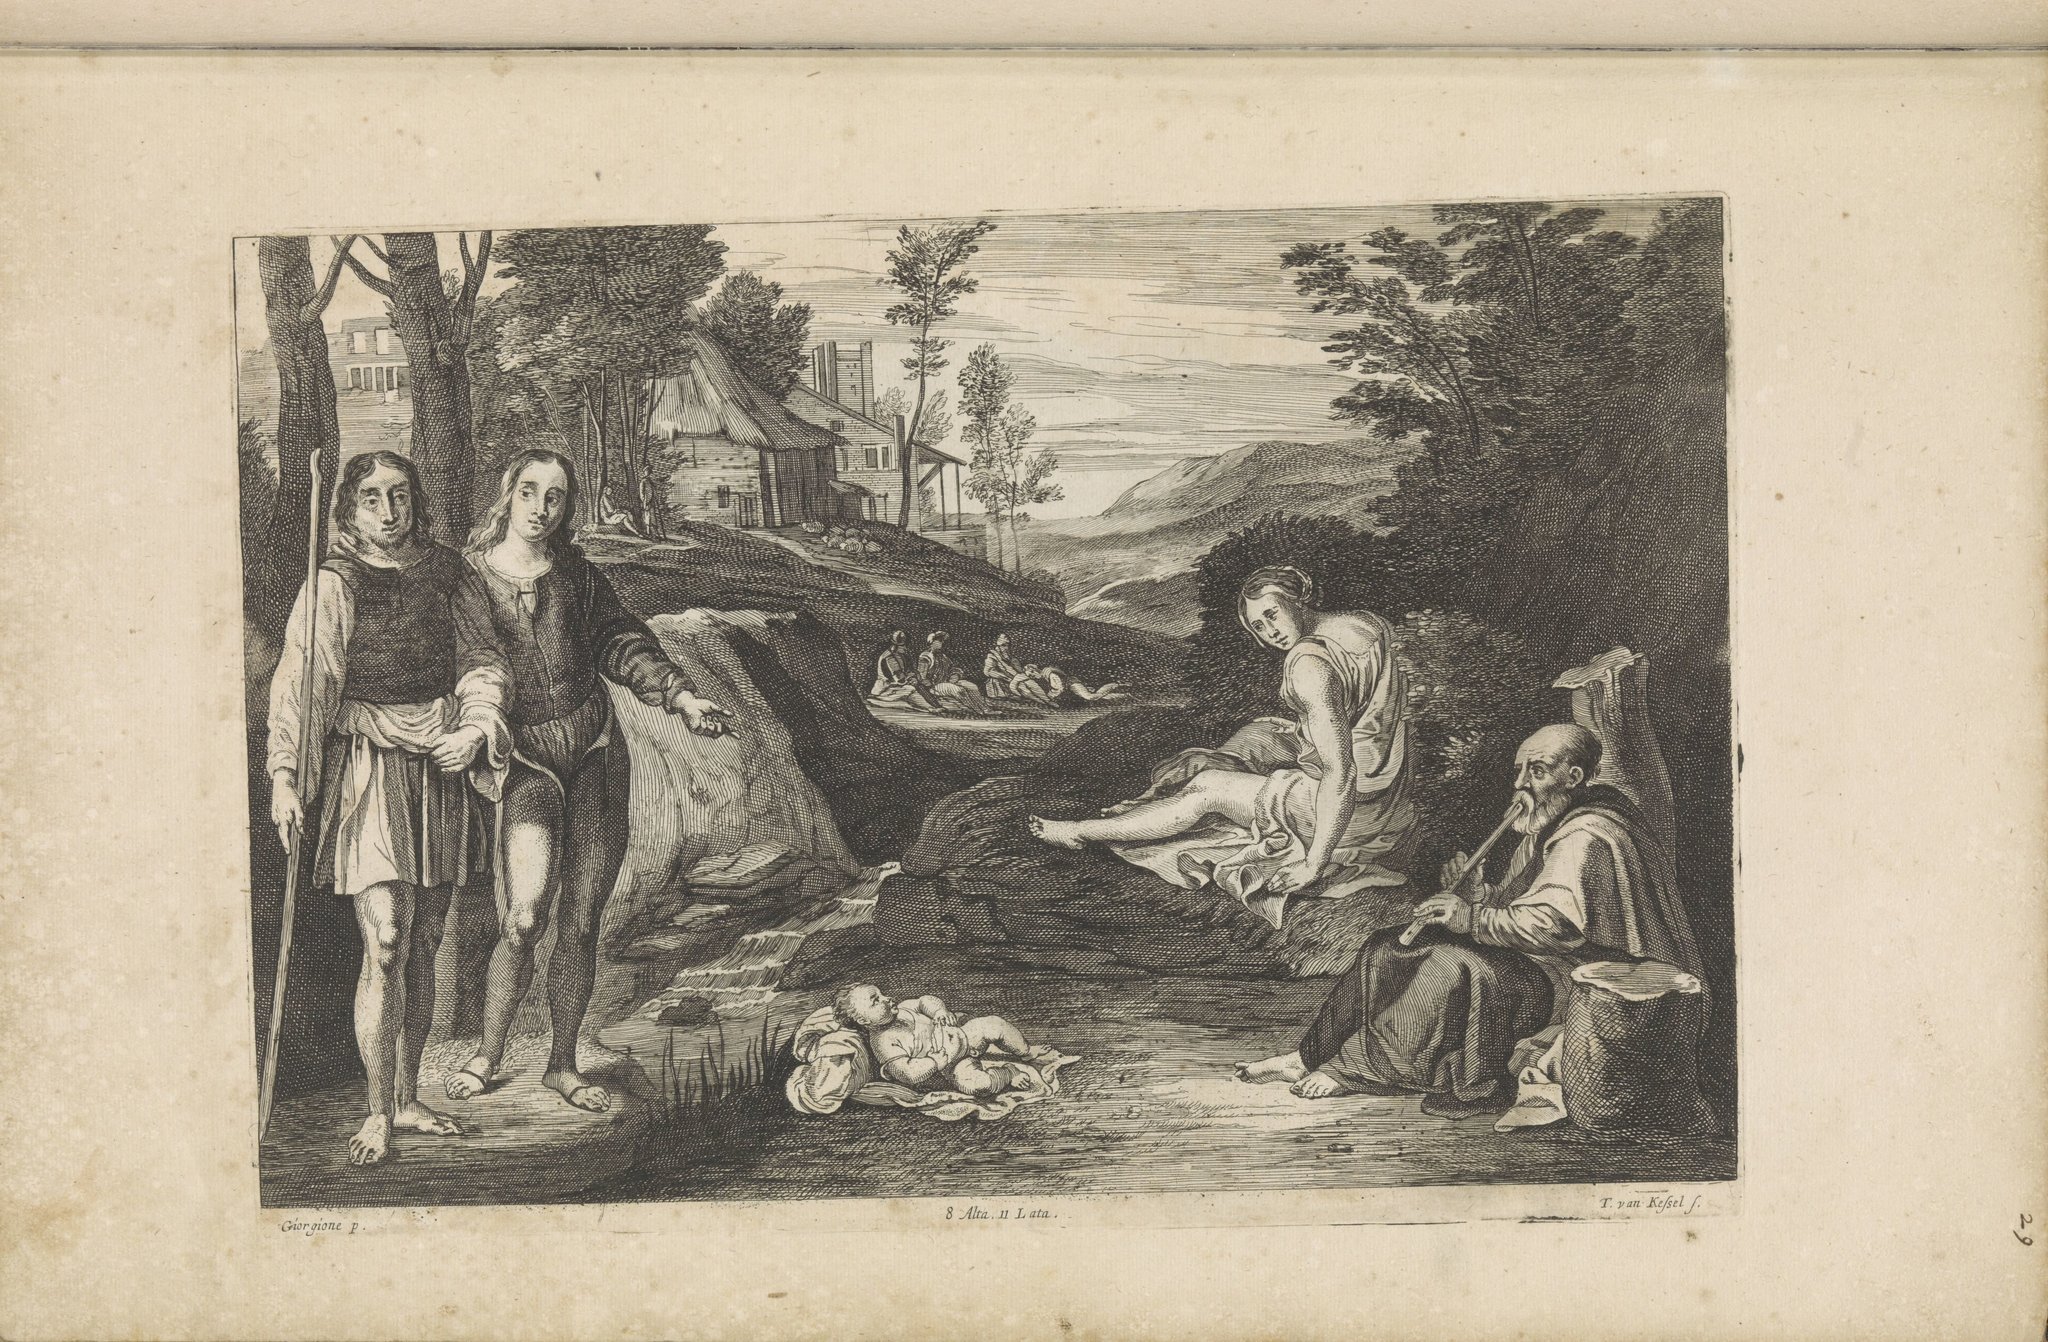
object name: album leaf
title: Herderspaar vindt Paris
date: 1660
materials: paper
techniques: engraving, etching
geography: antwerp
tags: paris with the shepherds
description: David Teniers heeft waarschijnlijk van alle schilderijen uit de collectie van Leopold Willem van Oostenrijk een olieverfstudie op doek of paneel vervaardigd (zgn. pasticcio), die als voorbeeld voor de prentmakers diende. Het is niet altijd duidelijk of de pasticci door hem zijn gemaakt of door zijn atelier. Niet alle pasticci zijn overgeleverd.